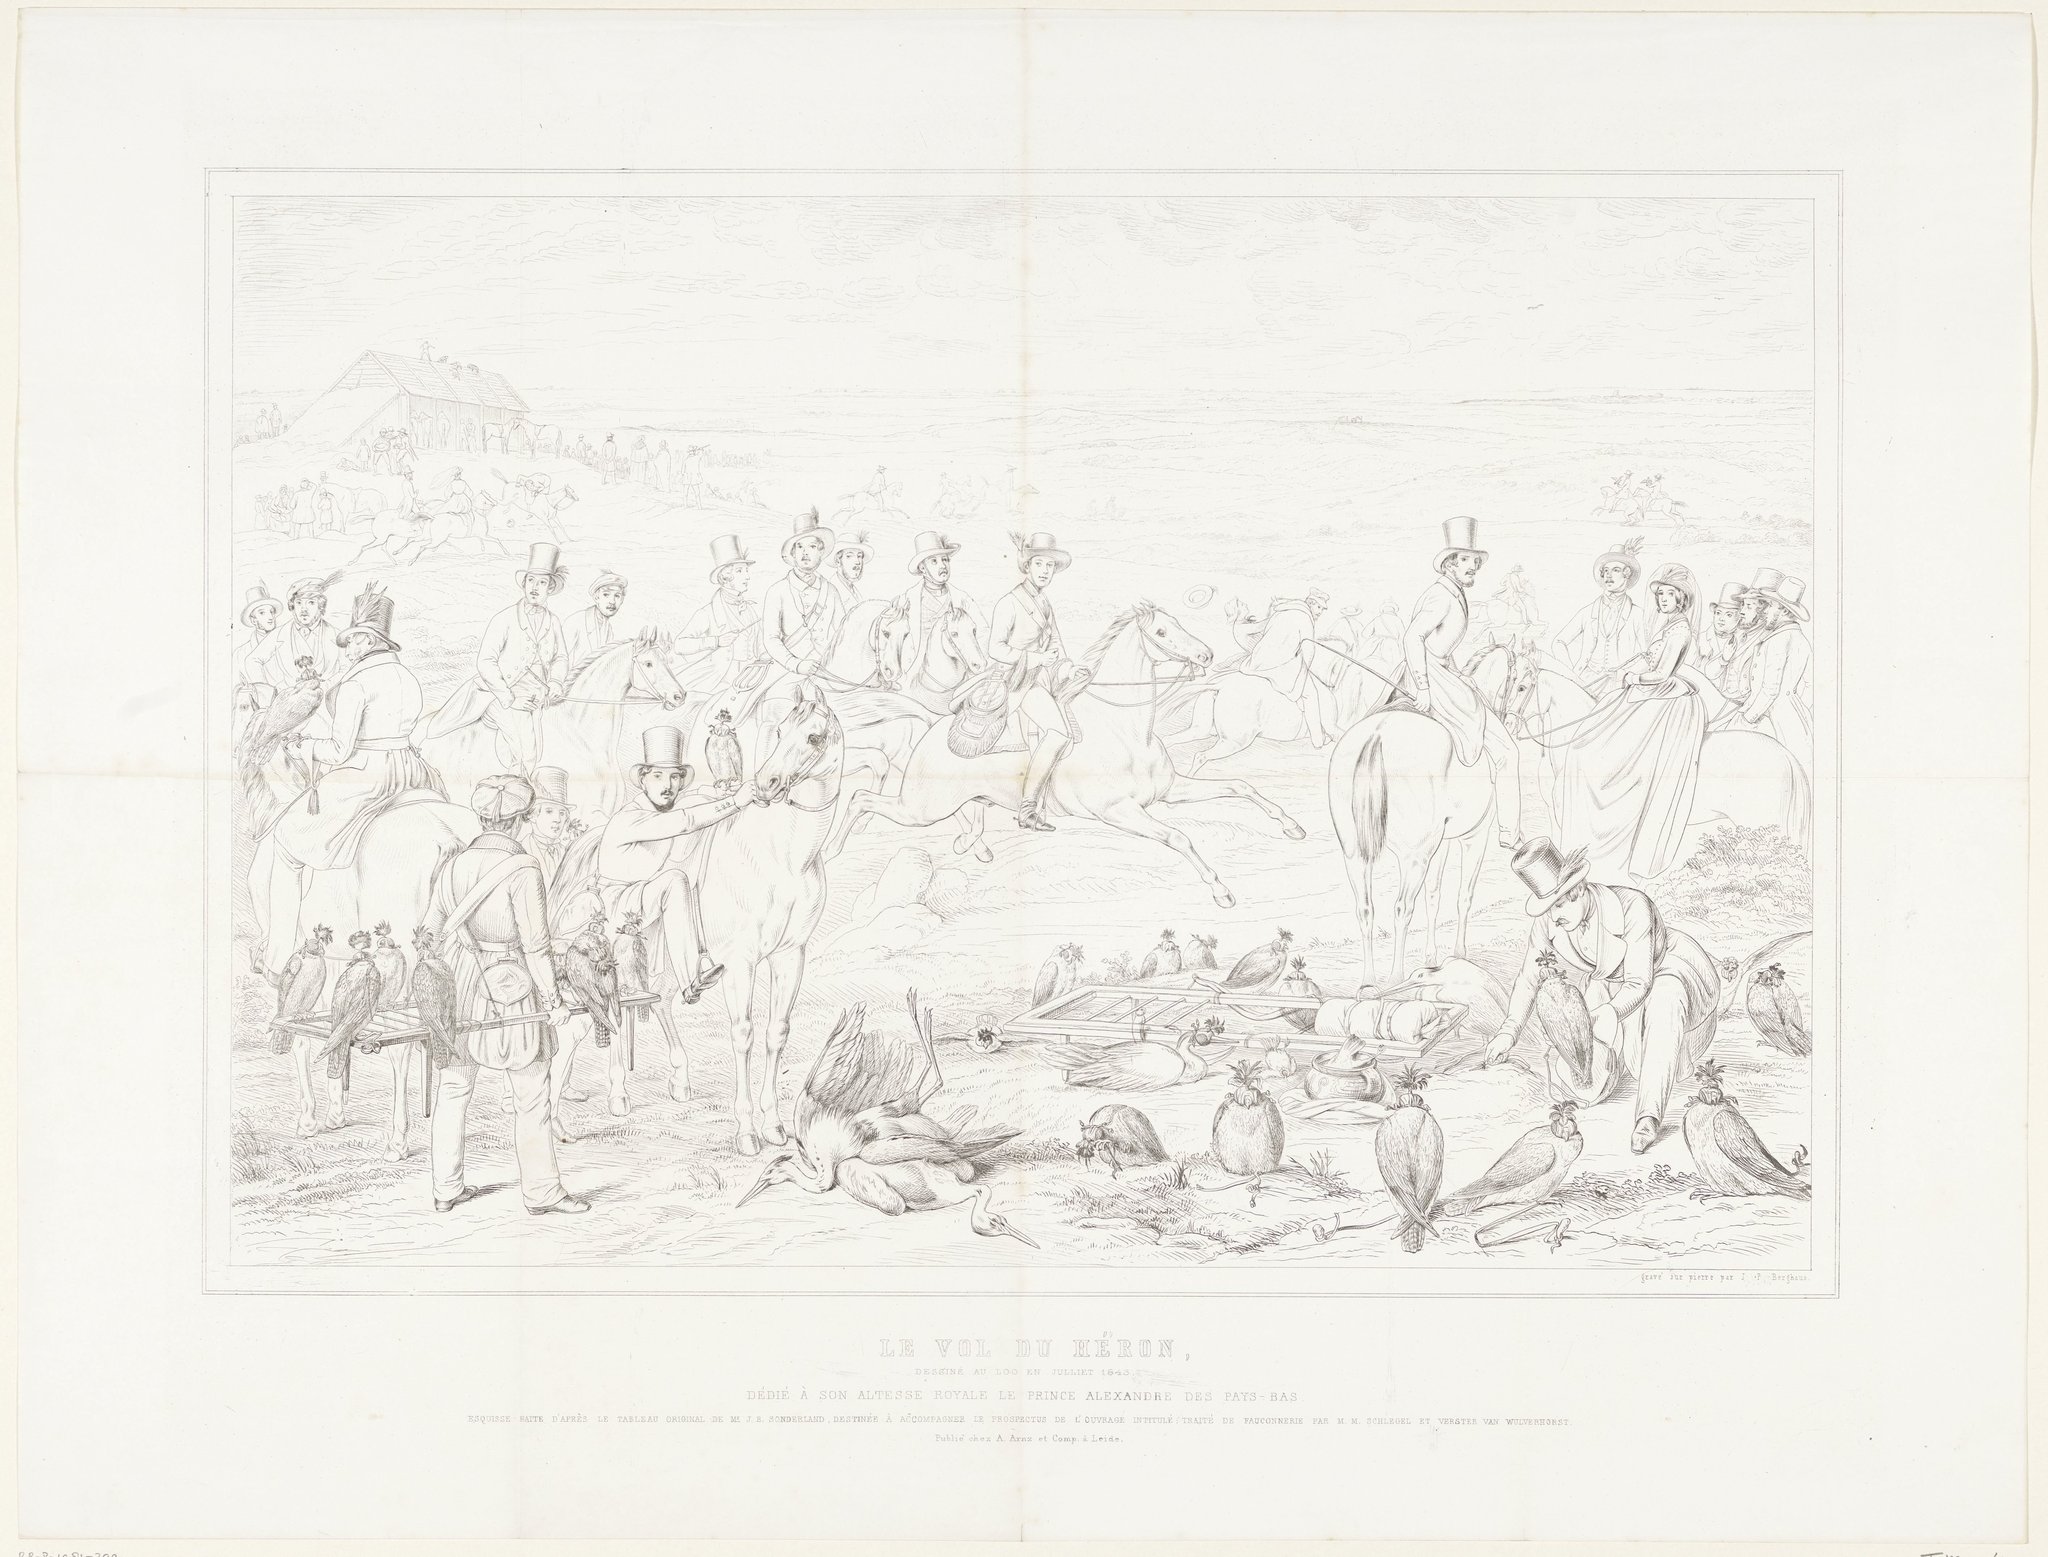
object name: print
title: Le Vol du Héron, dessiné au Loo en Julliet 1843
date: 1844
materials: paper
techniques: lithograph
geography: leiden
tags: alexander (prins der nederlanden, prins van oranje-nassau), predatory birds: falcon, shore-birds and wading-birds: heron, hunting, chase (+ hunting with falcon, hawk; falconry), netherlands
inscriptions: collector's mark: Lugt 2228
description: Valkenjacht gehouden in juli 1843 op de hei nabij Paleis Het Loo. Centraal te paard prins Alexander met zijn gevolg. Rechts kijken een dame en enkele heren te paard toe. Links een man met een rek waarop meerdere valken zitten, vooraan enkele gevangen reigers. Prins Alexander was voorzitter van de Royal Loo Hawking Club, twee andere leden, Fr. van den Heuvel en Adriaan Mollen zijn links geportretteerd. Behoort bij de prospectus voor een reeks van zeventien platen over de valkenjacht, het eerste deel te verschijnen in oktober 1844, als proeve van illustratie.